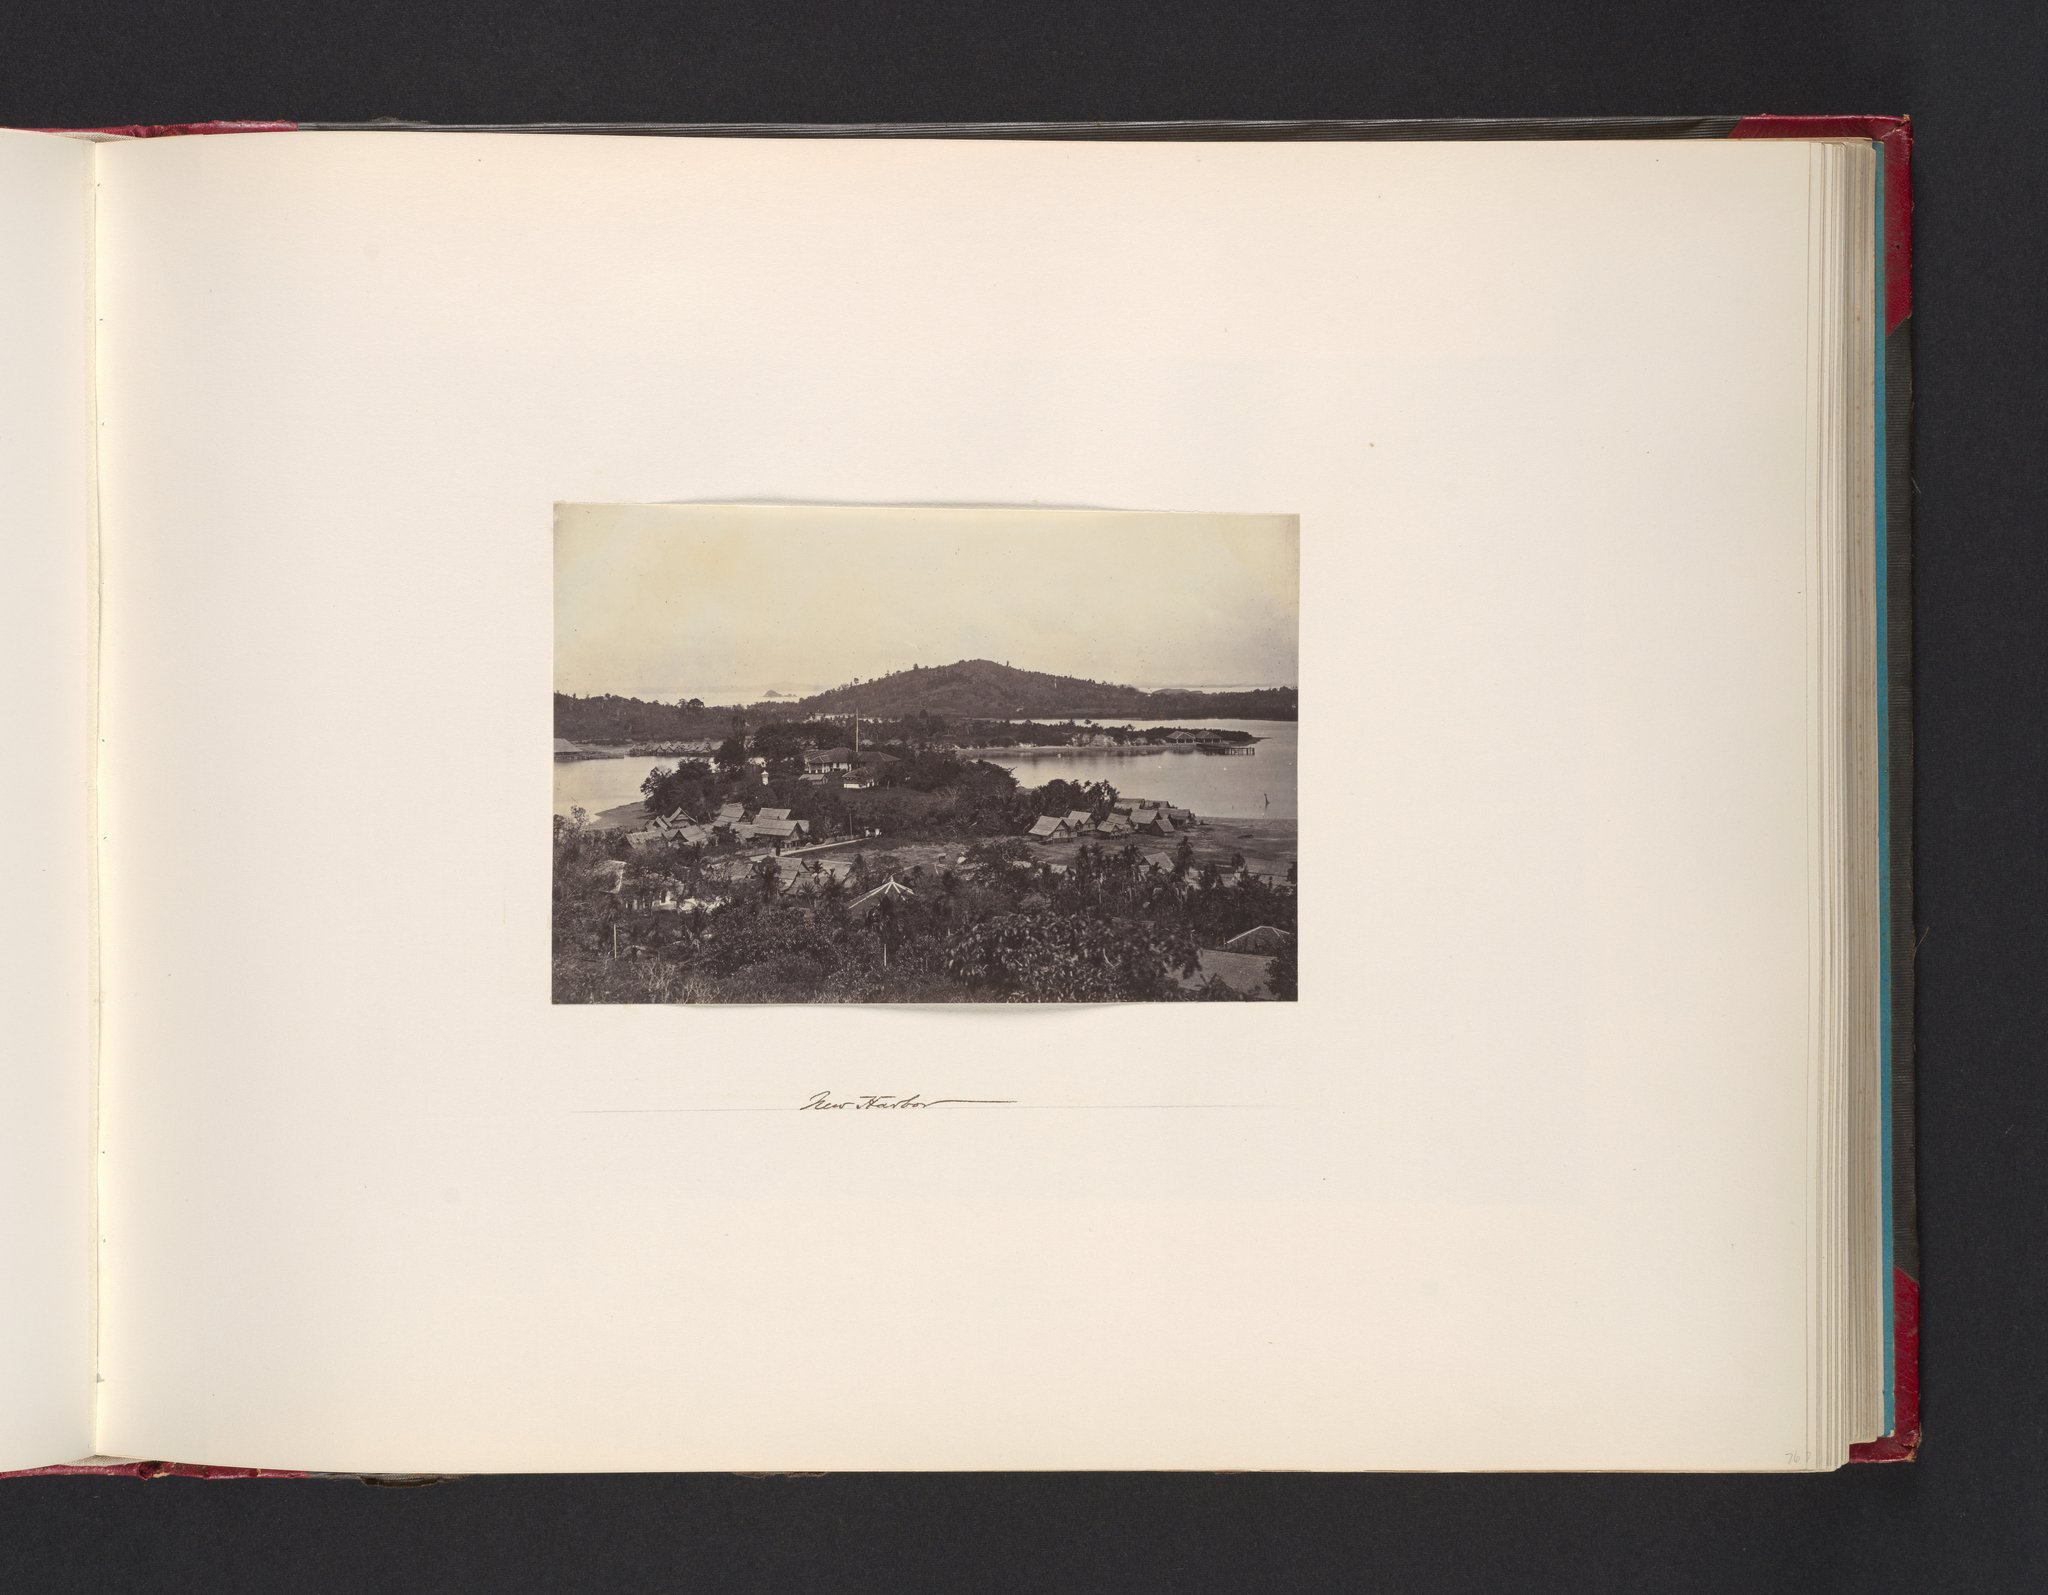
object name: photograph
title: New Harbor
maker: john thomson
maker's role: artist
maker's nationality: british, scottish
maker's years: 1837-1921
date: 1865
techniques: albumen silver print, glass negative